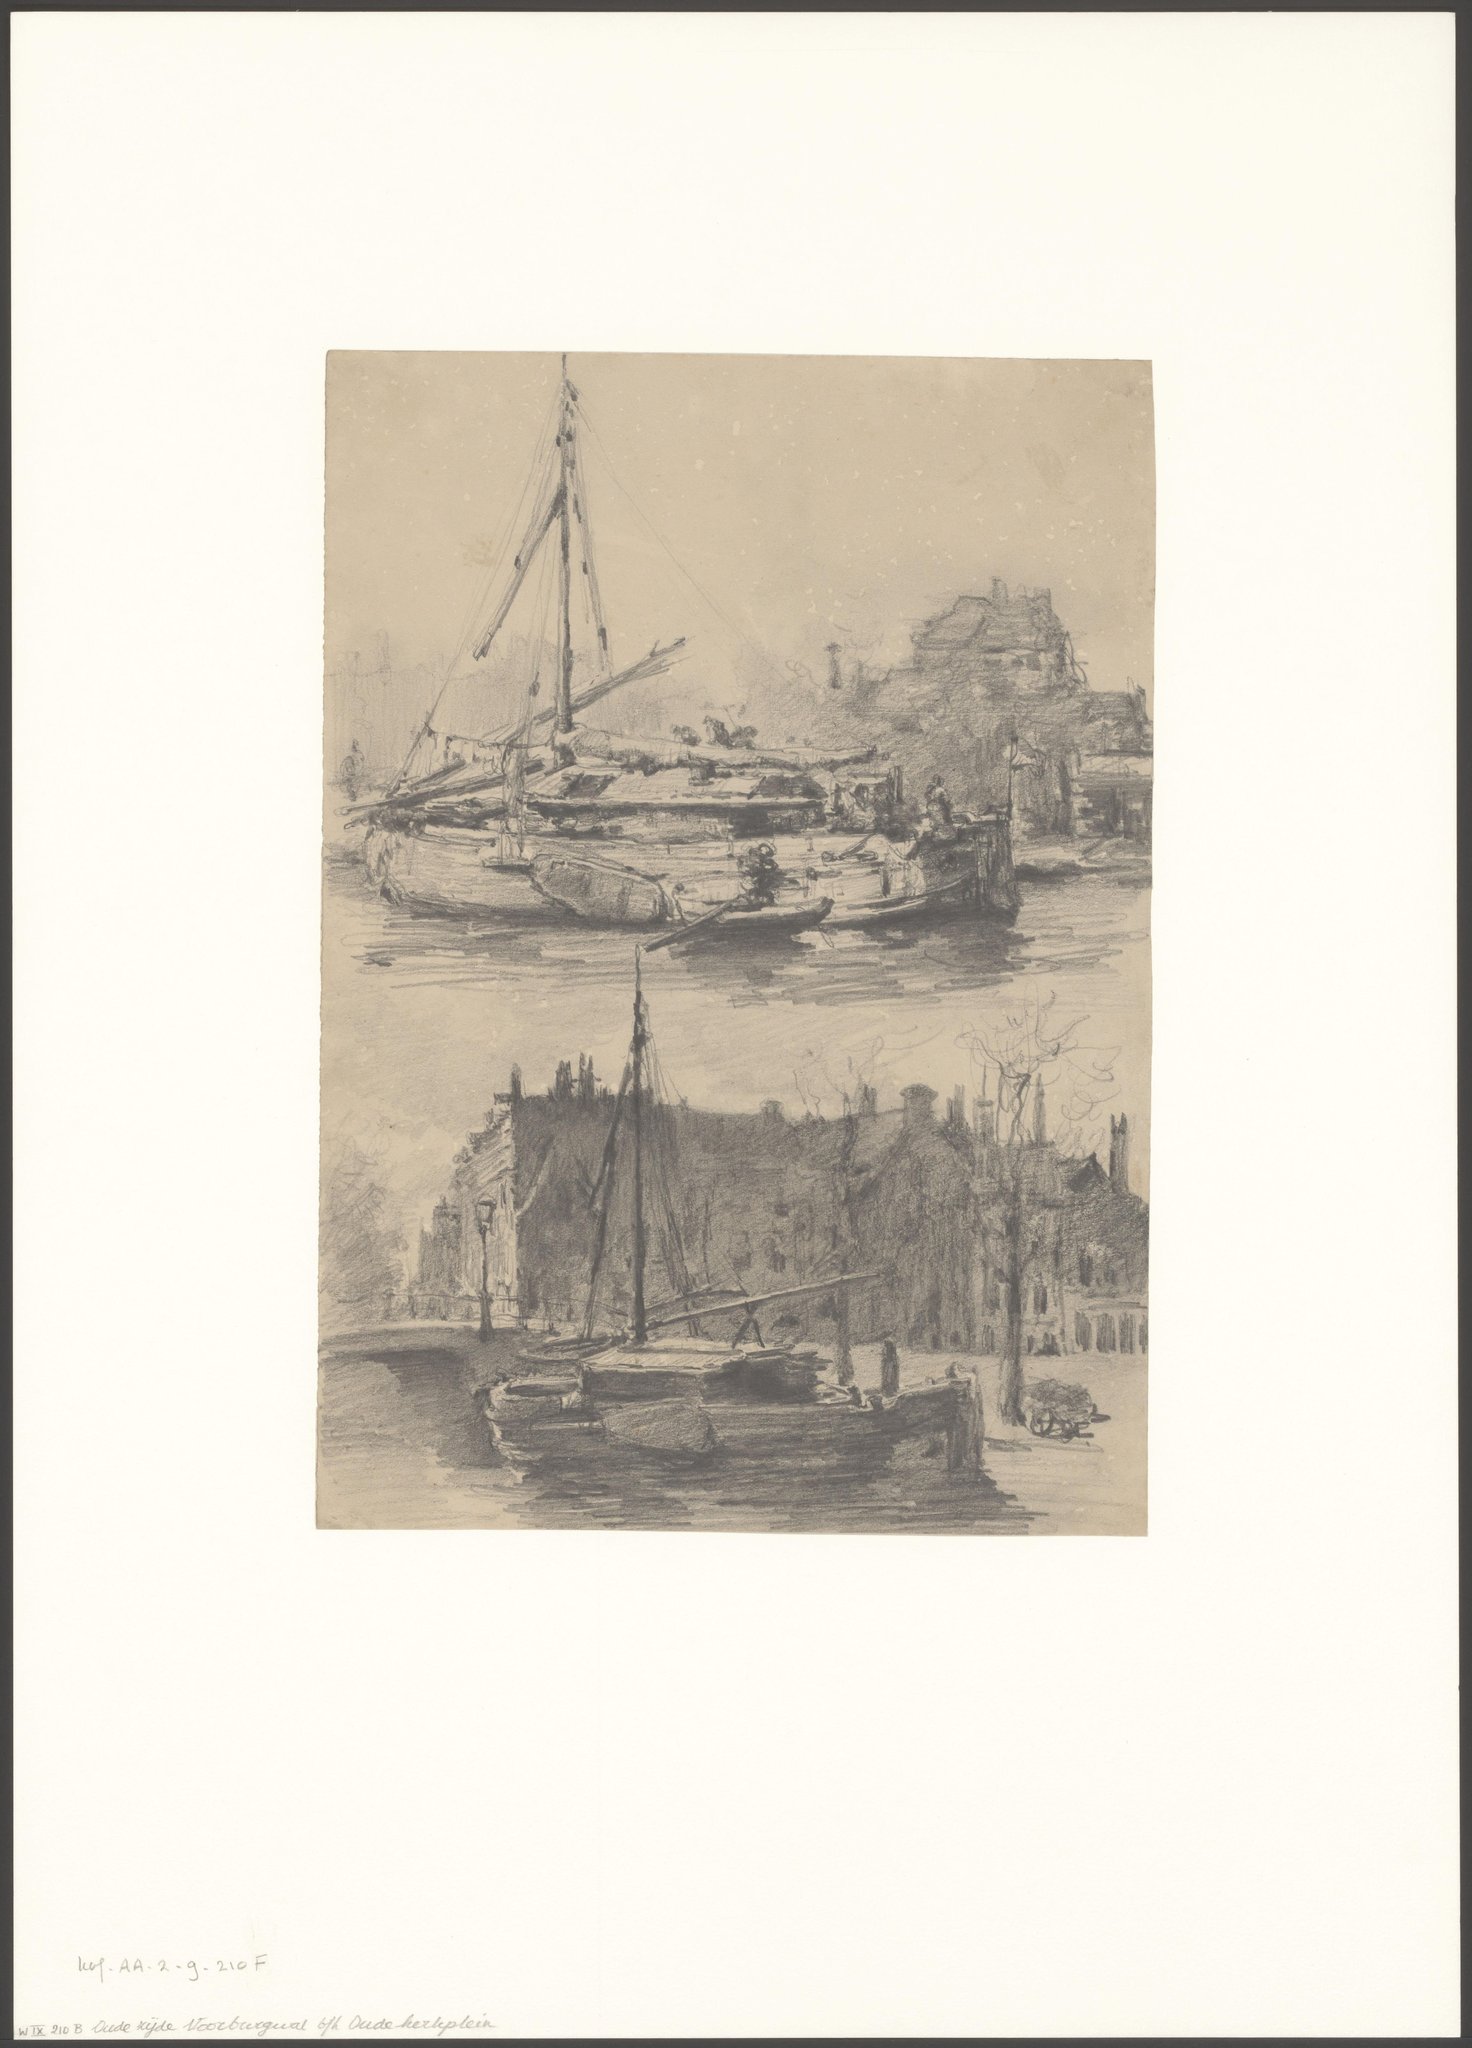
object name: drawing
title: Gezicht op de Oudezijds Voorburgwal bij het Oudekerksplein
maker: Anonymous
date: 1800-1899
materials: ink, paper, pencil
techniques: brush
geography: amsterdam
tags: sailing-ship, sailing-boat, city-view in general; 'veduta', canal, church (exterior), bridge in city across river, canal, etc.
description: Tekening binnen de Atlas Van Eck ingedeeld op wijknummer 9.